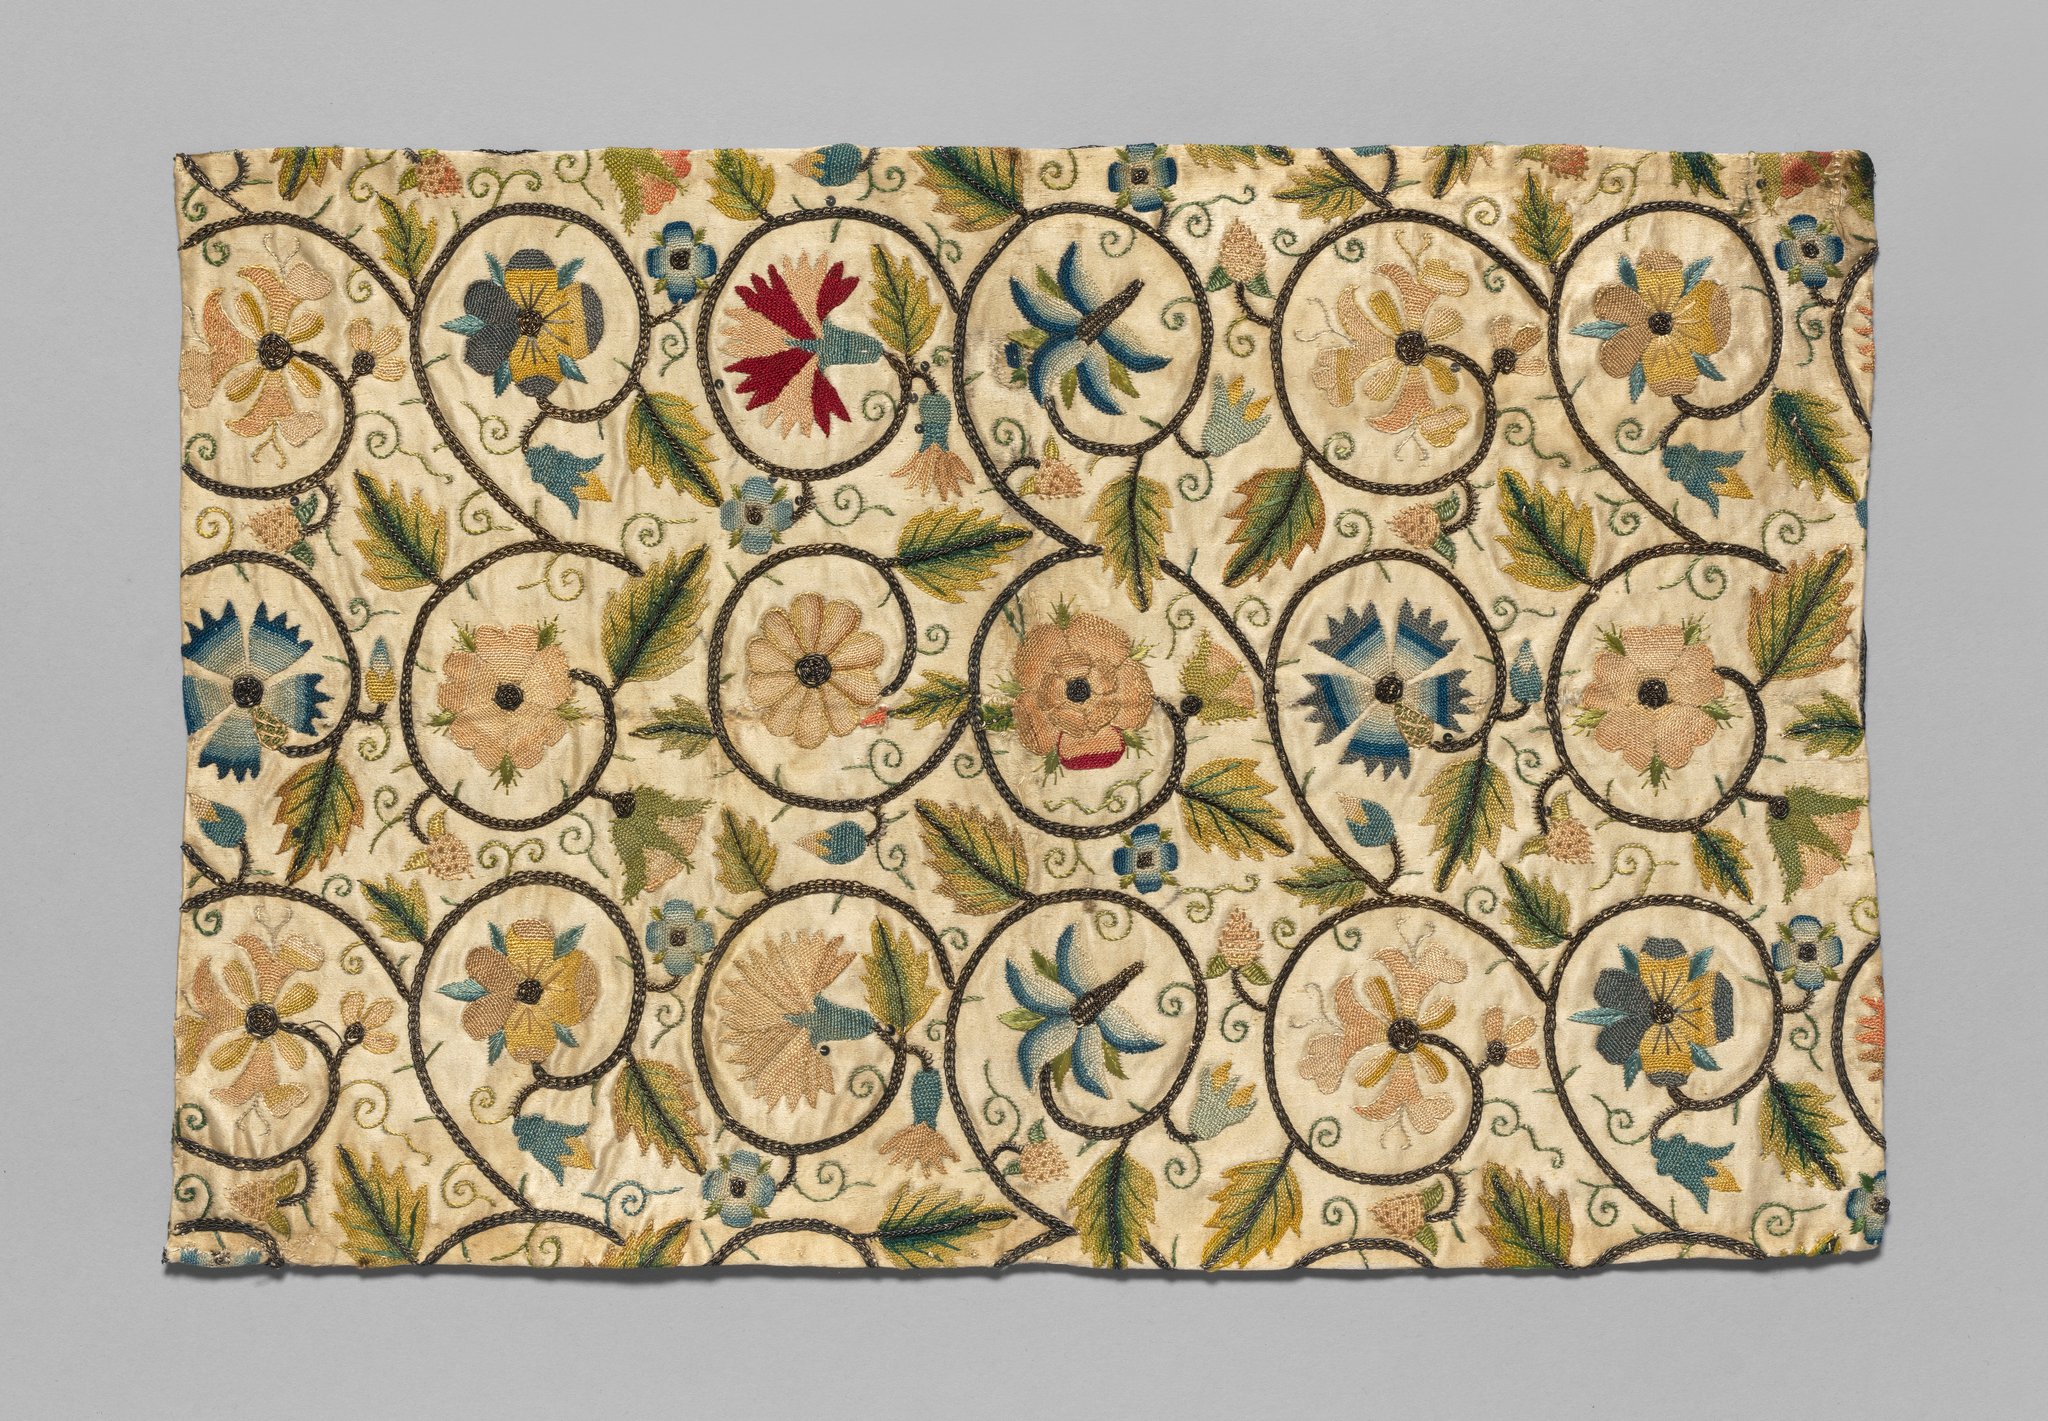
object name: panel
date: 1625-1650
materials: metal, silk, thread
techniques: embroidery